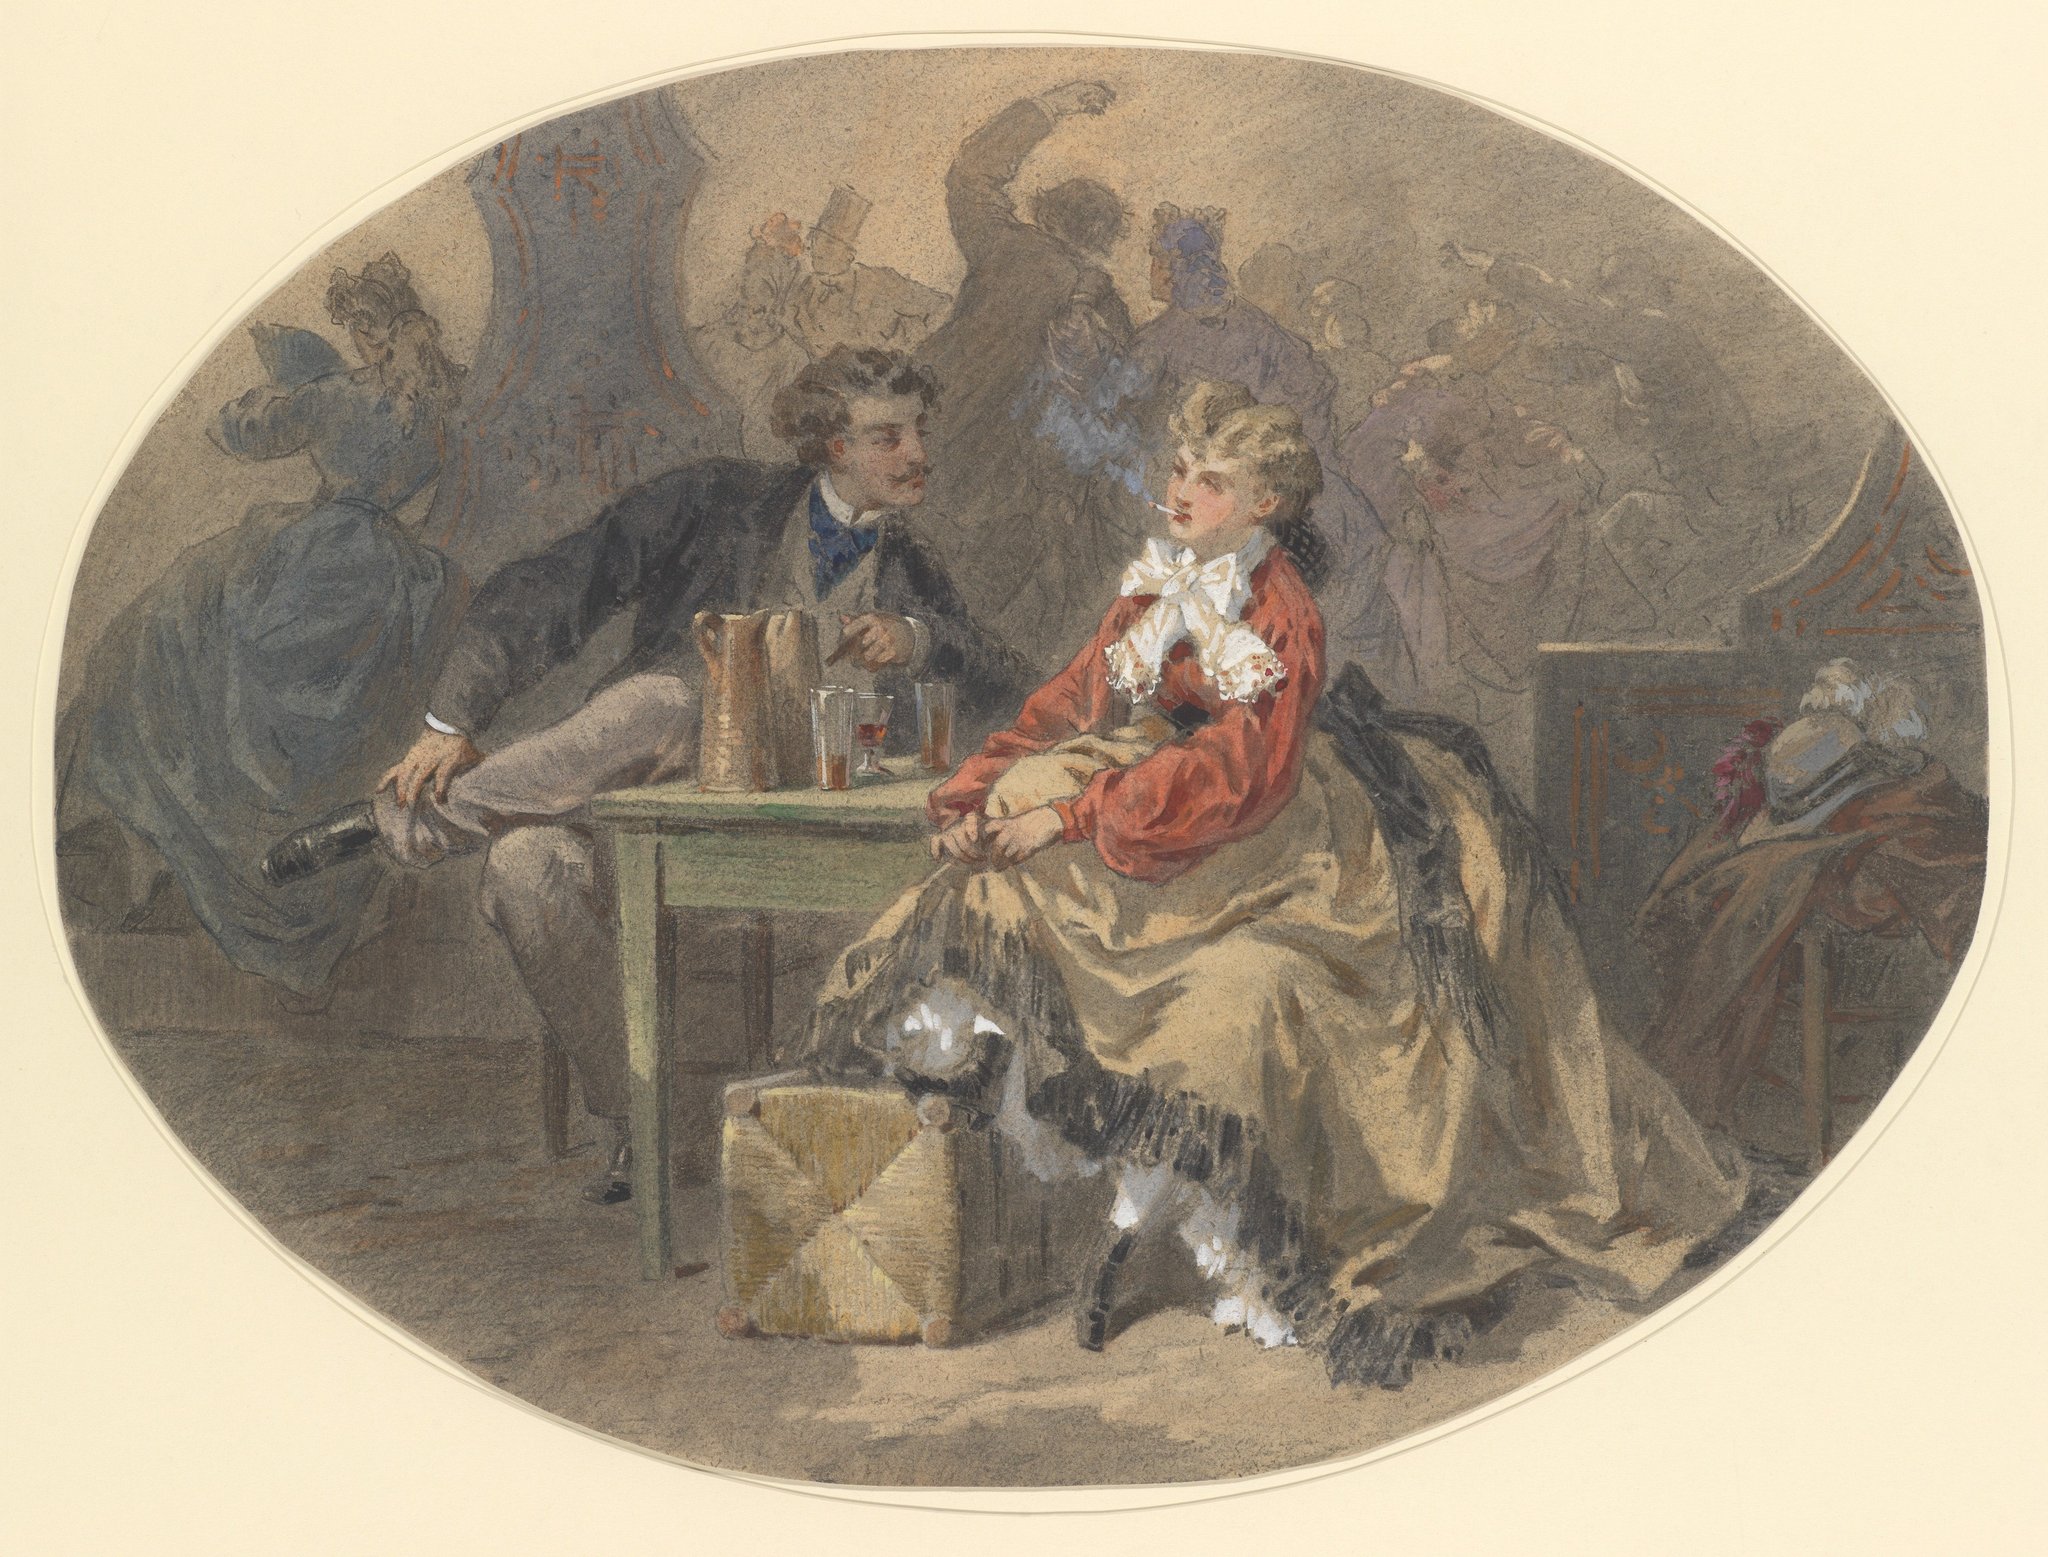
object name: drawing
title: Un Mari Pour Rire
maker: paul-emile-anthony morlon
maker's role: artist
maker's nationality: french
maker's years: 1845-1905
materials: chalk, watercolor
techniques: heightening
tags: men,women,smoking